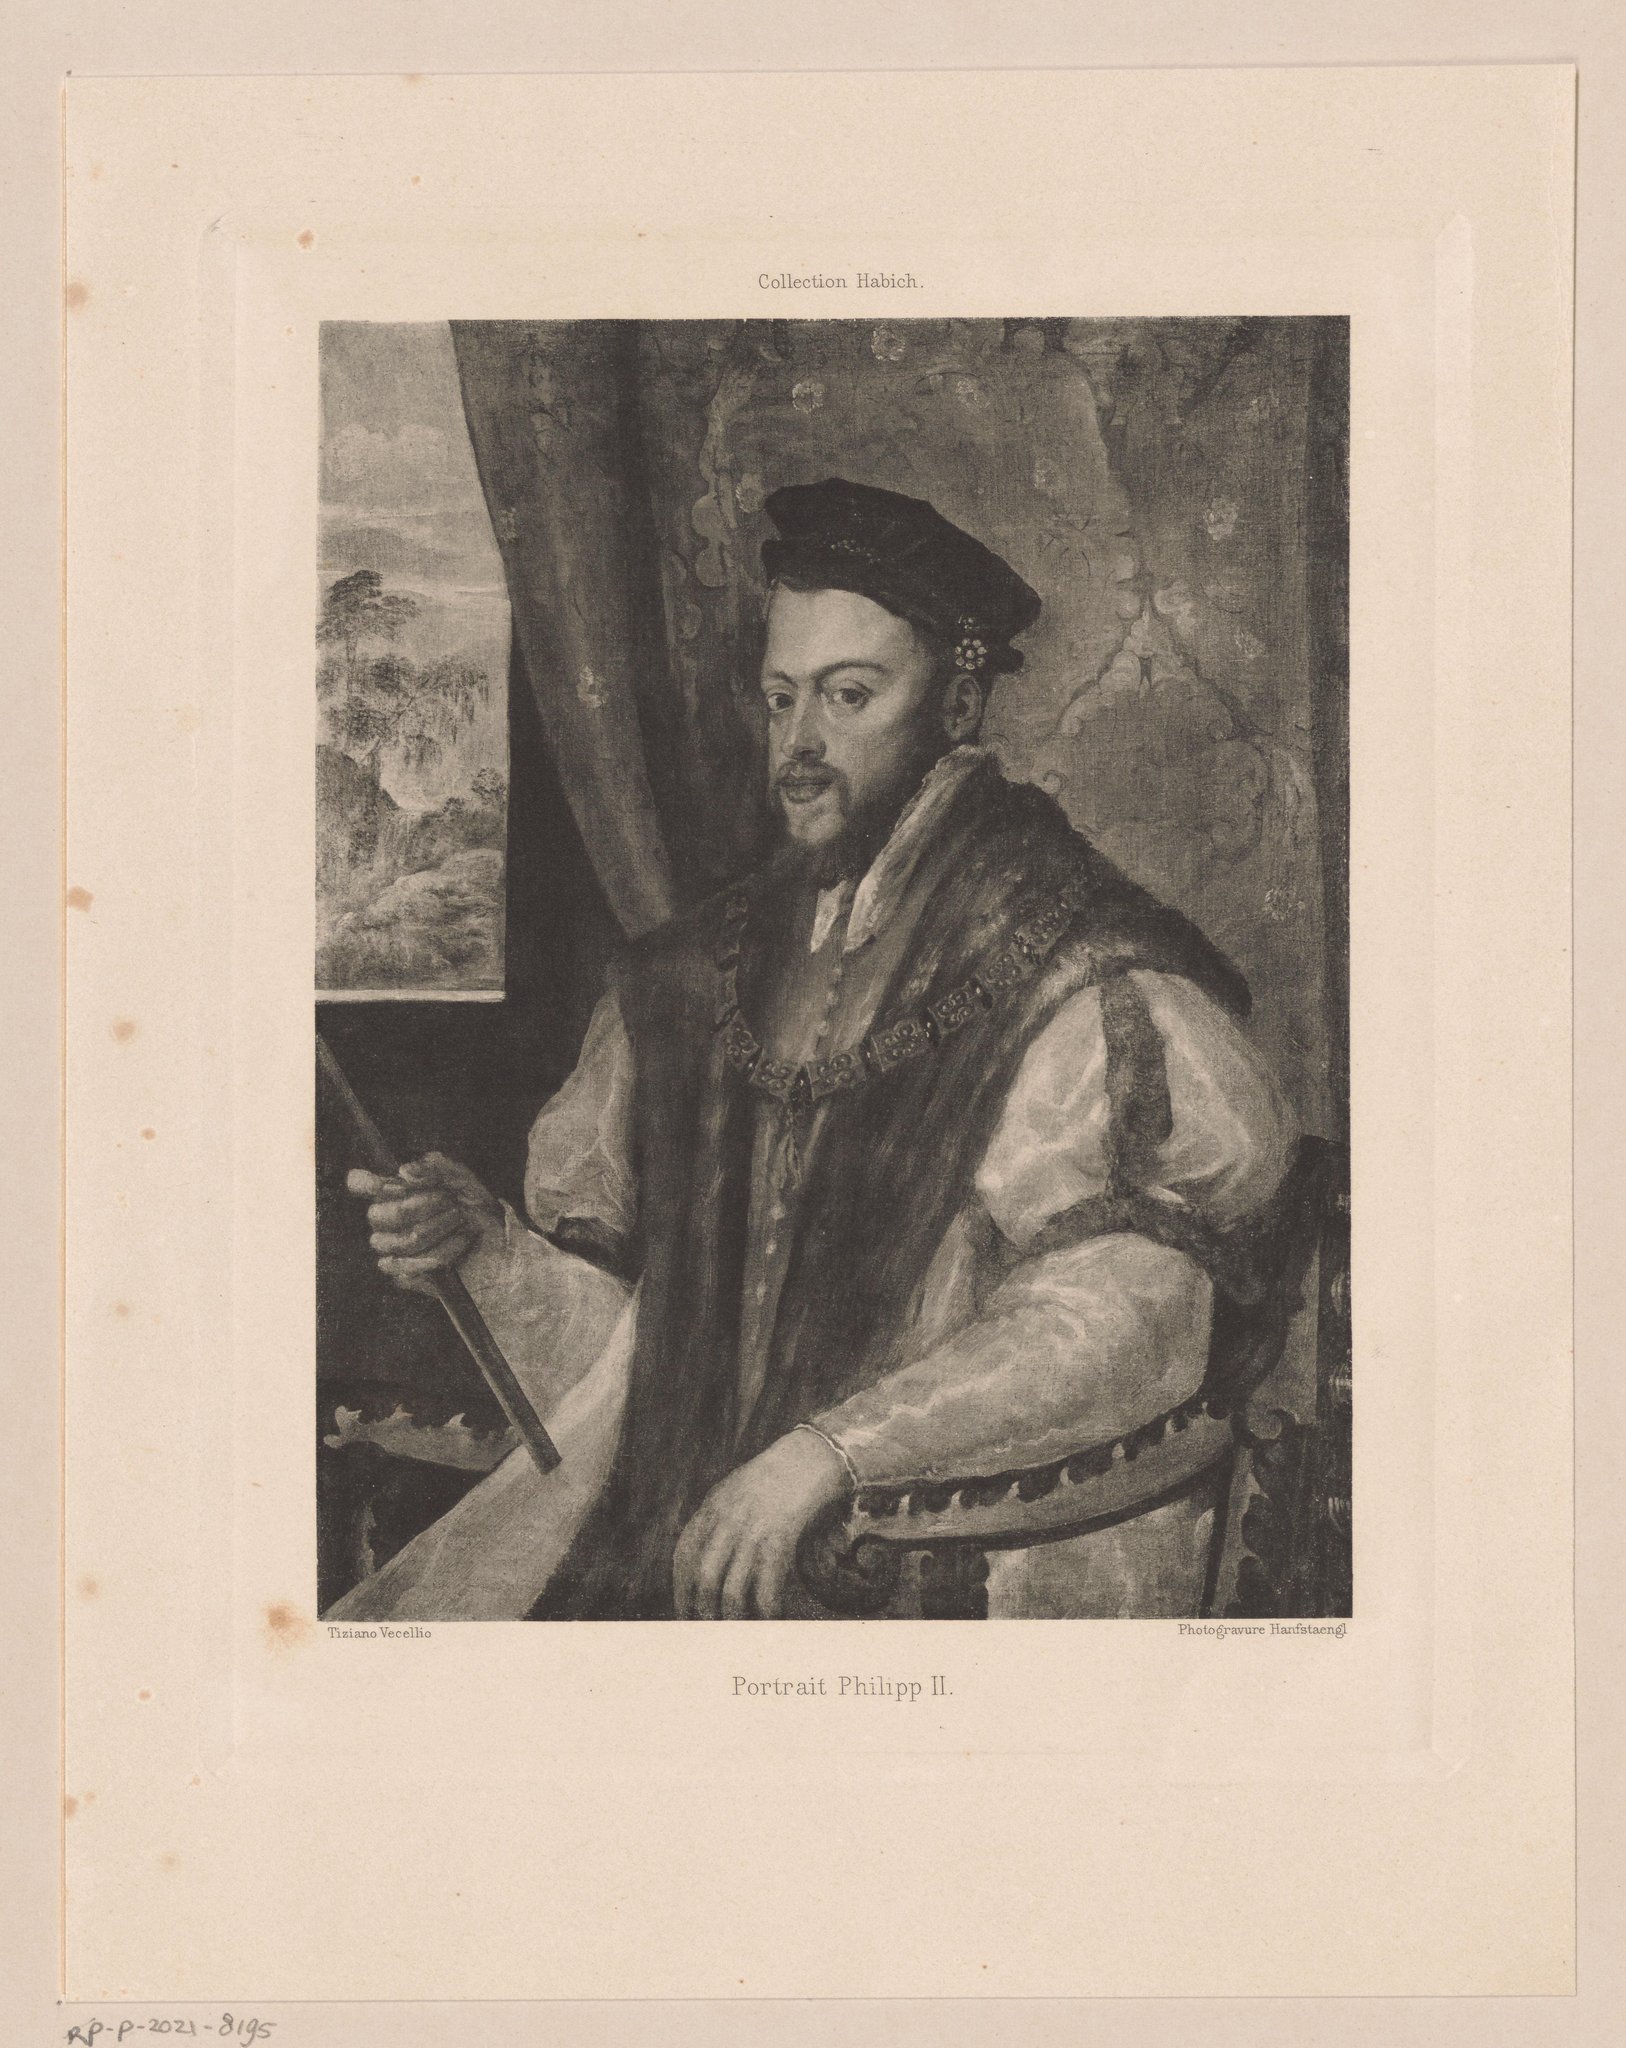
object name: photomechanical print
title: Portret van Filips II, koning van Spanje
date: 1870-1877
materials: paper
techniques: photoaquatint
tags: philip ii of spain, adult man, historical persons